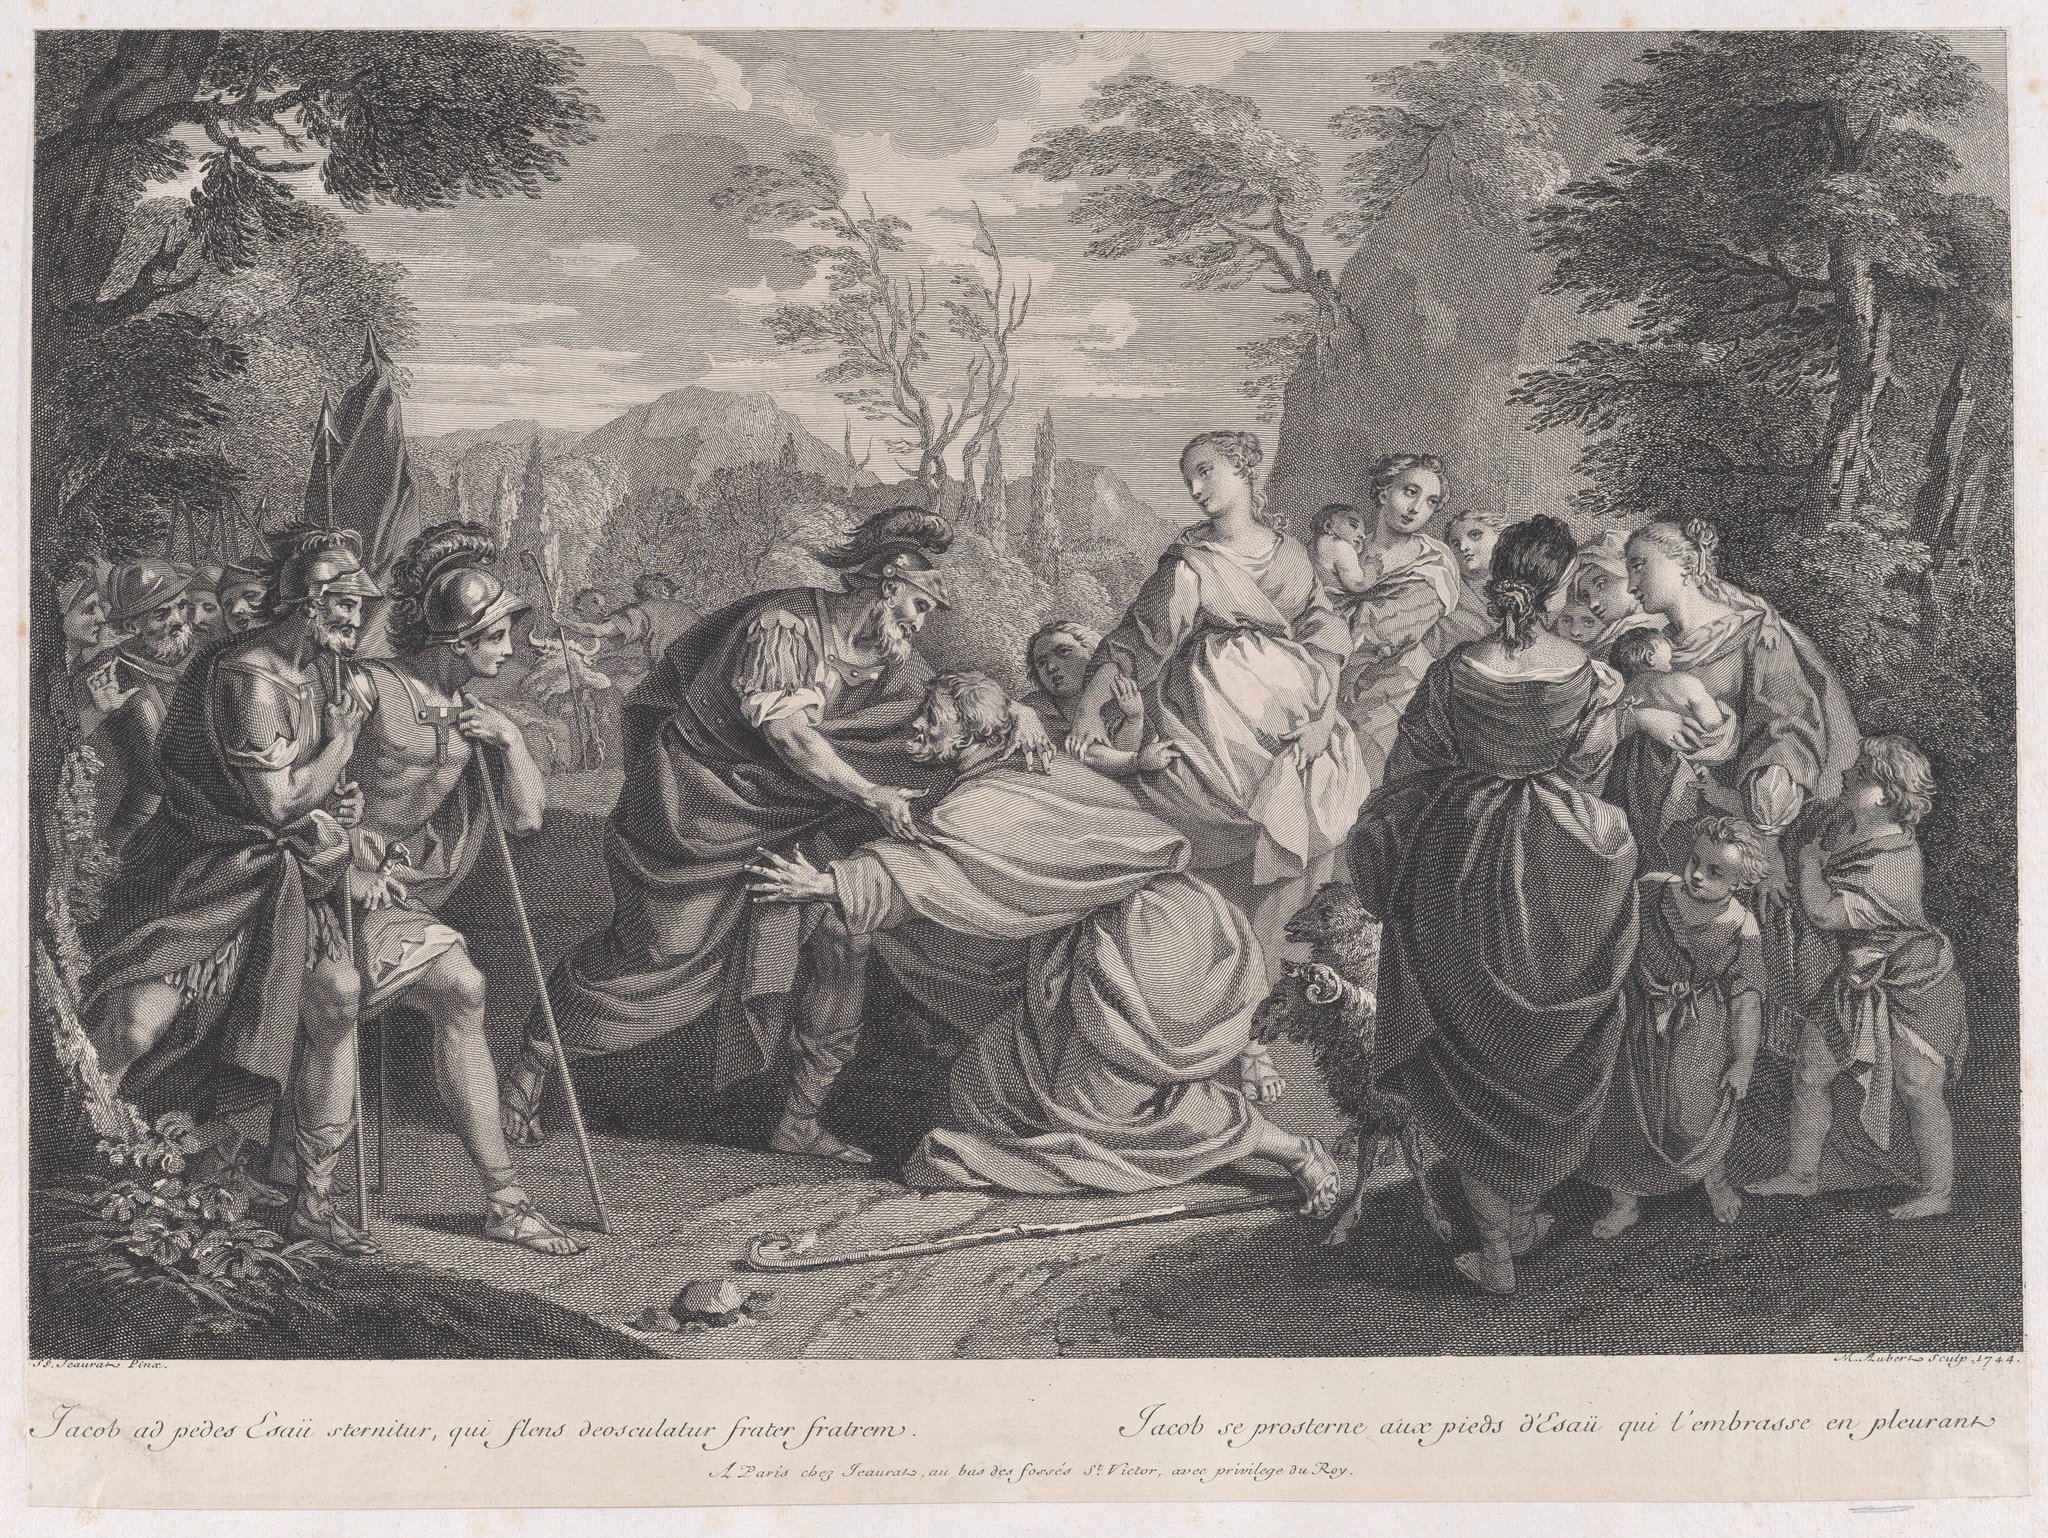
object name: print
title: Jacob Prostrates Himself before Esau, after Etienne Jeaurat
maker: michel aubert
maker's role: artist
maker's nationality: french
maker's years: 1700-1757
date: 1744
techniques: etching